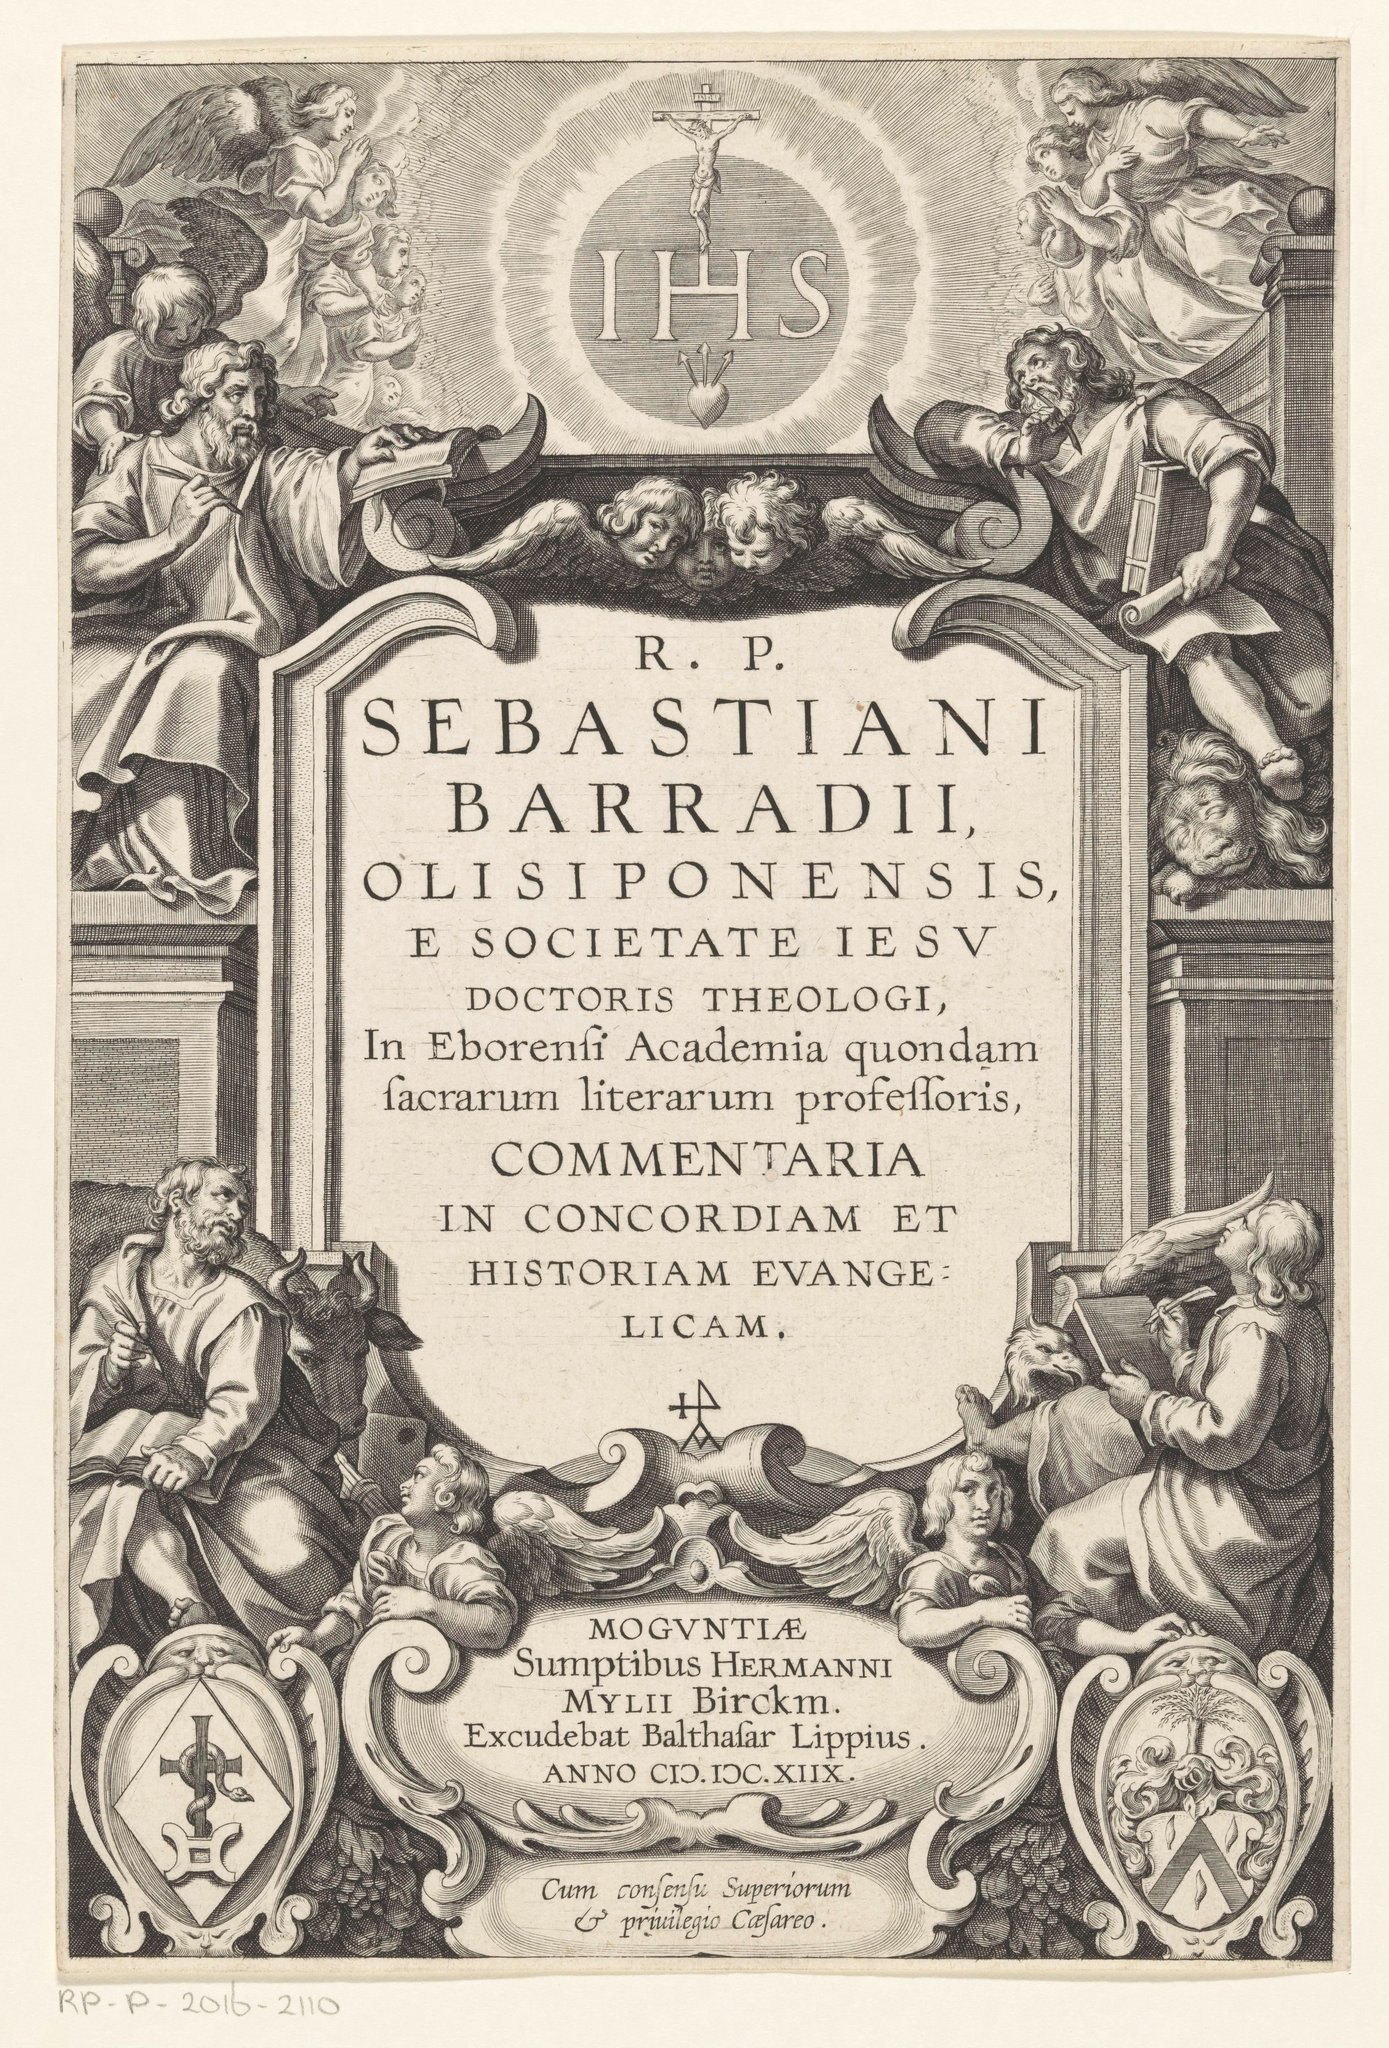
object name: print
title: Titelpagina voor: Sebastião Barradas, Olisiponensis e societate Iesu, 1618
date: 1618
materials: paper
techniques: engraving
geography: mainz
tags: the evangelists writing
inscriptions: collector's mark: Lugt 2228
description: De vier evangelisten met boeken en de vier bijbehorende wezens zitten rondom de titel. Daarboven verschijnt het monogram IHS en een duif in stralenkrans als symbool van de Heilige Geest. Omringd door putti en engelen op wolken.